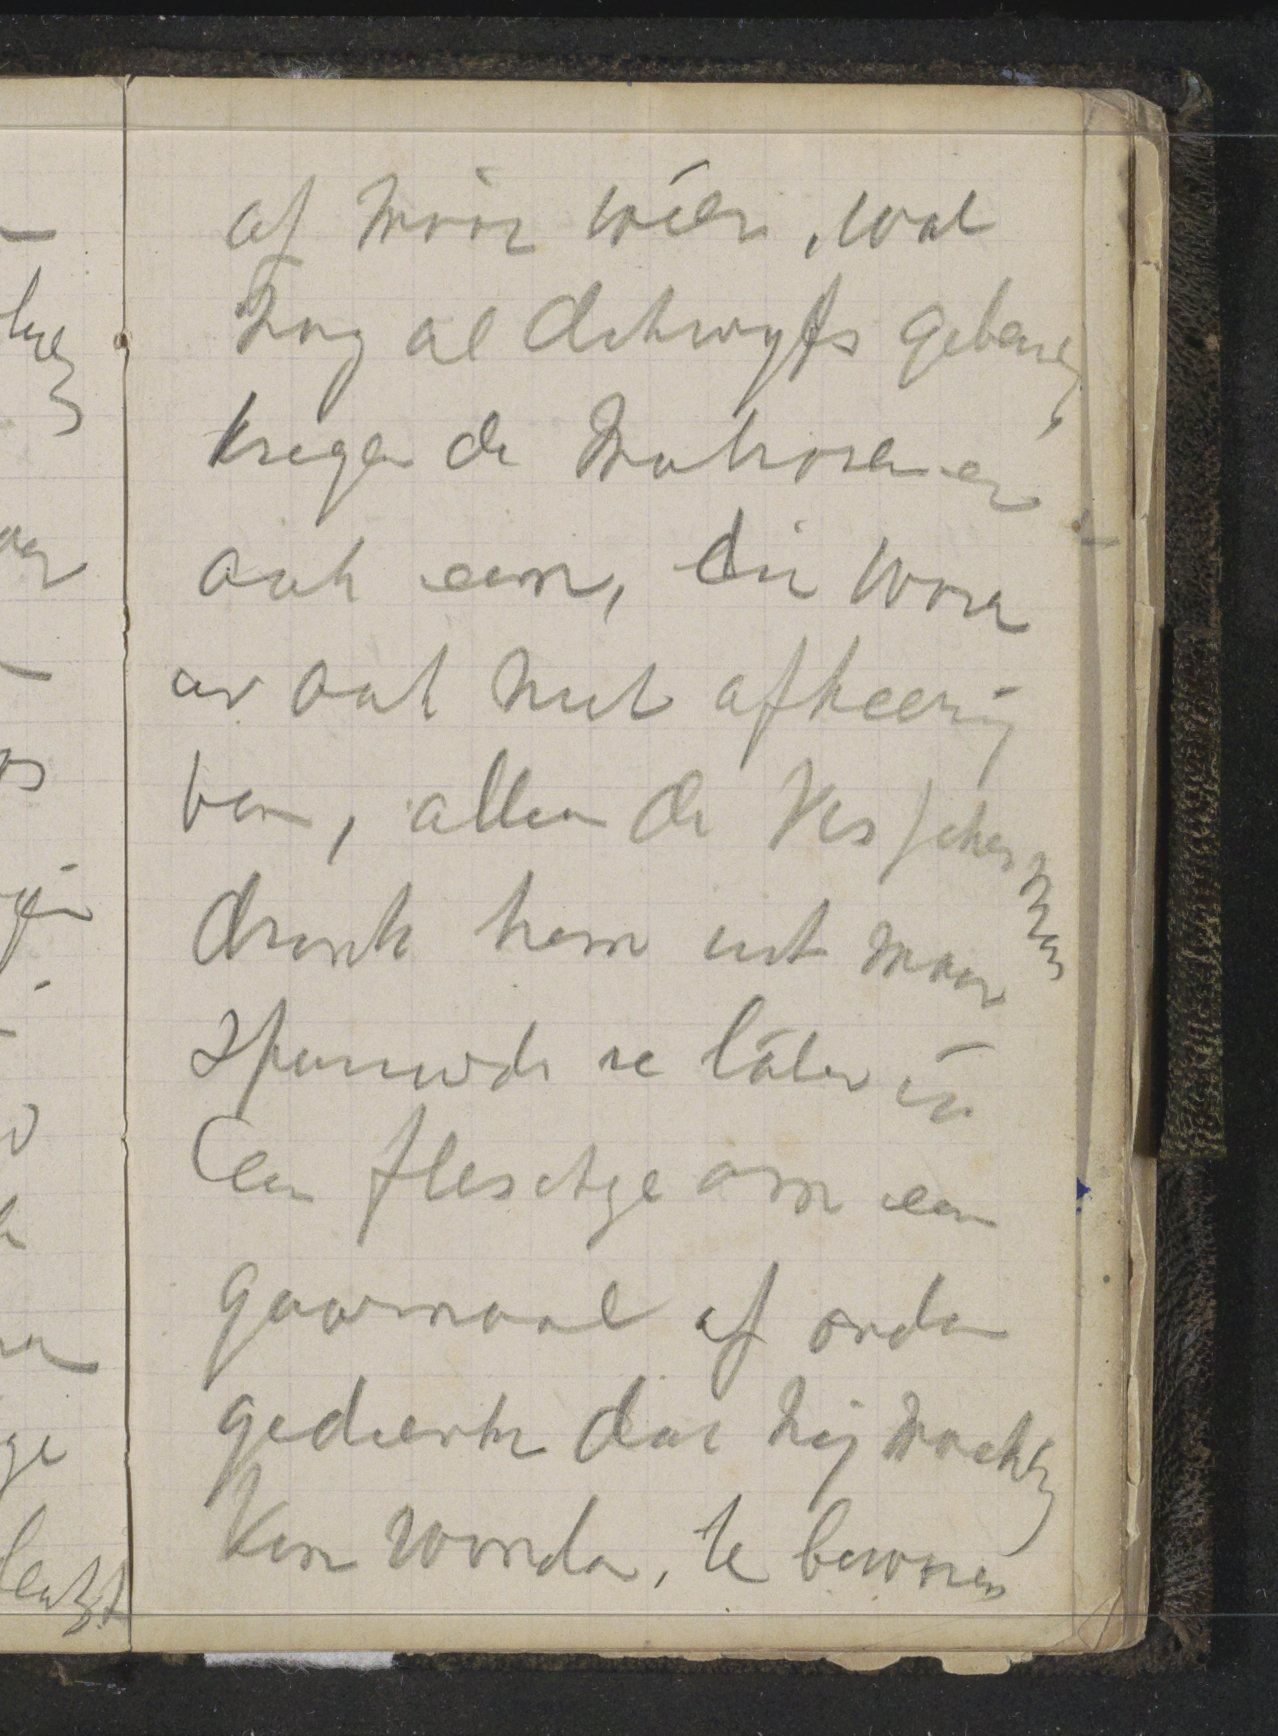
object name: sketchbook leaf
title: Reisverslag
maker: louis apol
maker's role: draughtsman, painter, print maker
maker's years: 1850-1936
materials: pencil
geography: novaya zemlya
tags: nova zembla expedities 1880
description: Blad 87 recto uit een schetsboek met 110 bladen betekend tijdens de expeditie naar Nova Zembla in 1880.